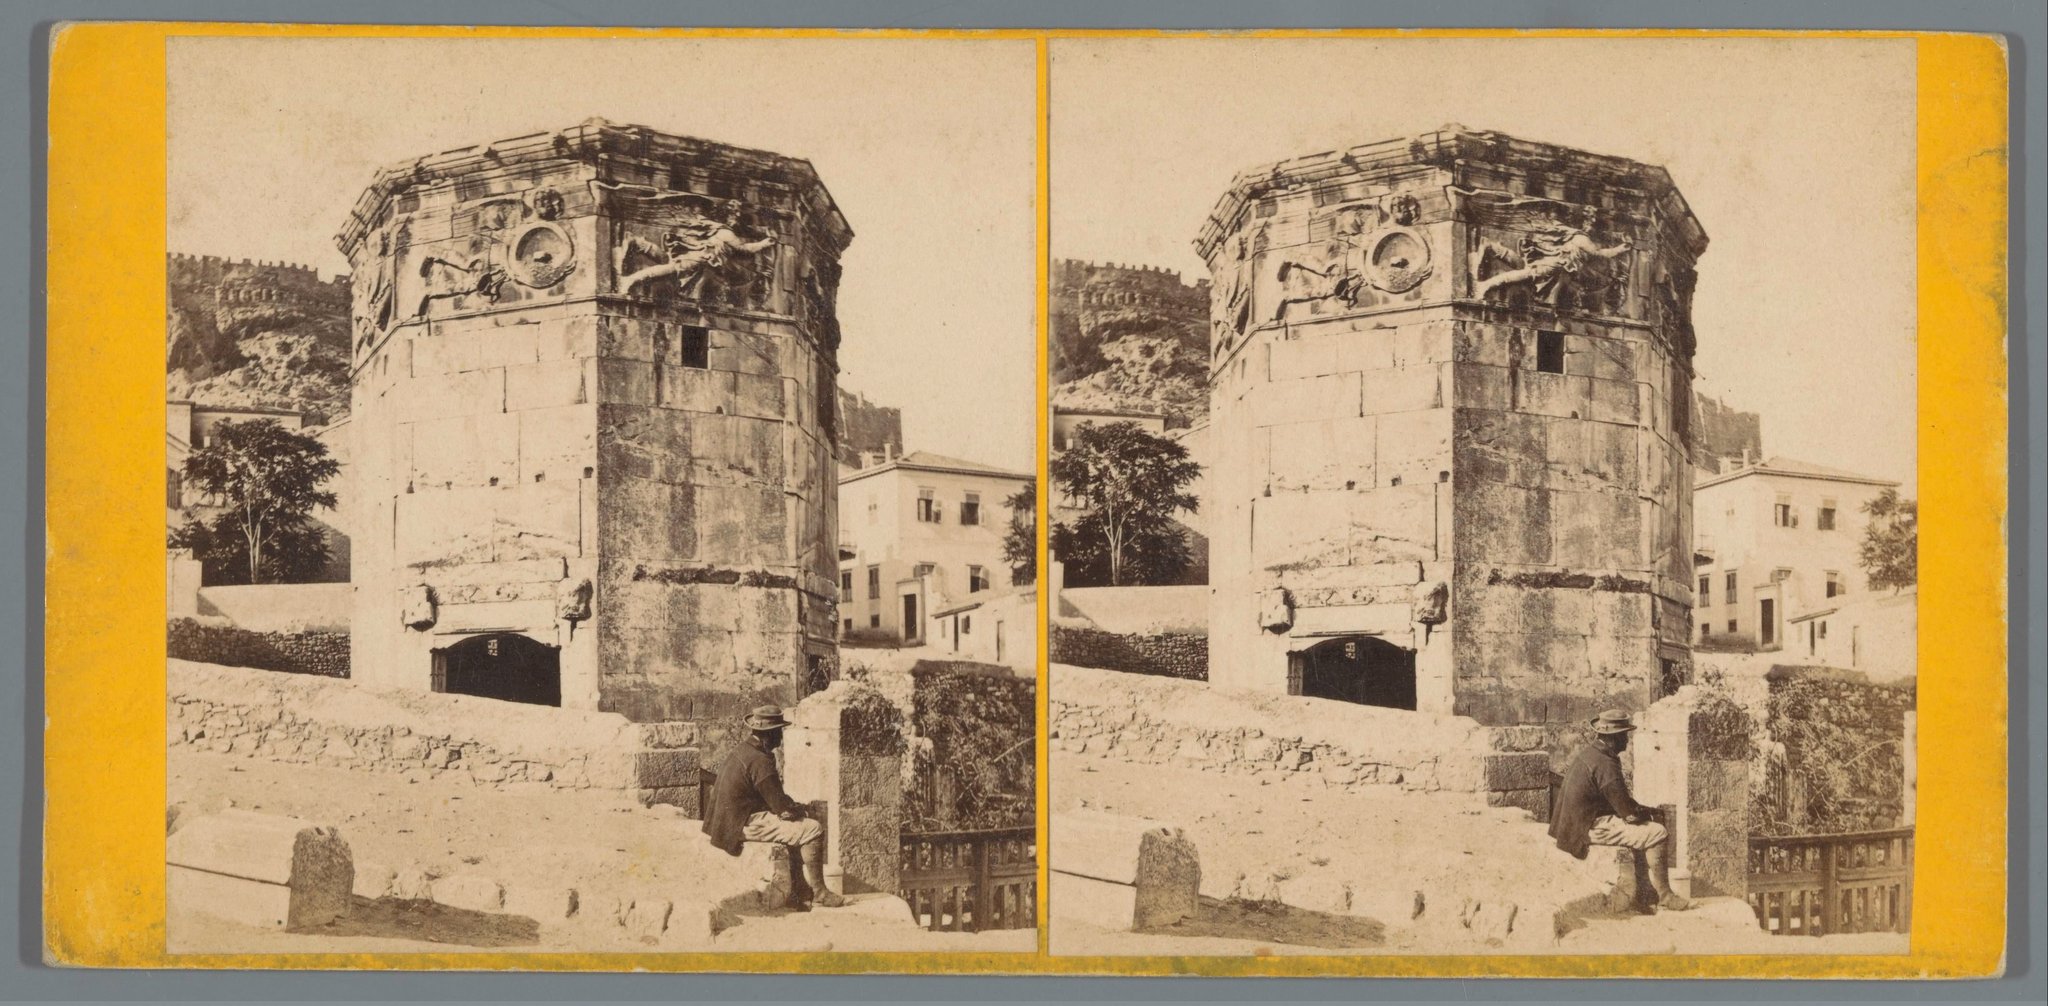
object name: stereograph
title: Athens.- The Temple of the Winds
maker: frank mason good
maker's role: publisher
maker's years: 1839-1928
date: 1860-1880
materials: cardboard, paper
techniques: albumen print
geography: london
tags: water tower, tower, clock tower ~ monumental adornment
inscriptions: number: ‘No. 88’